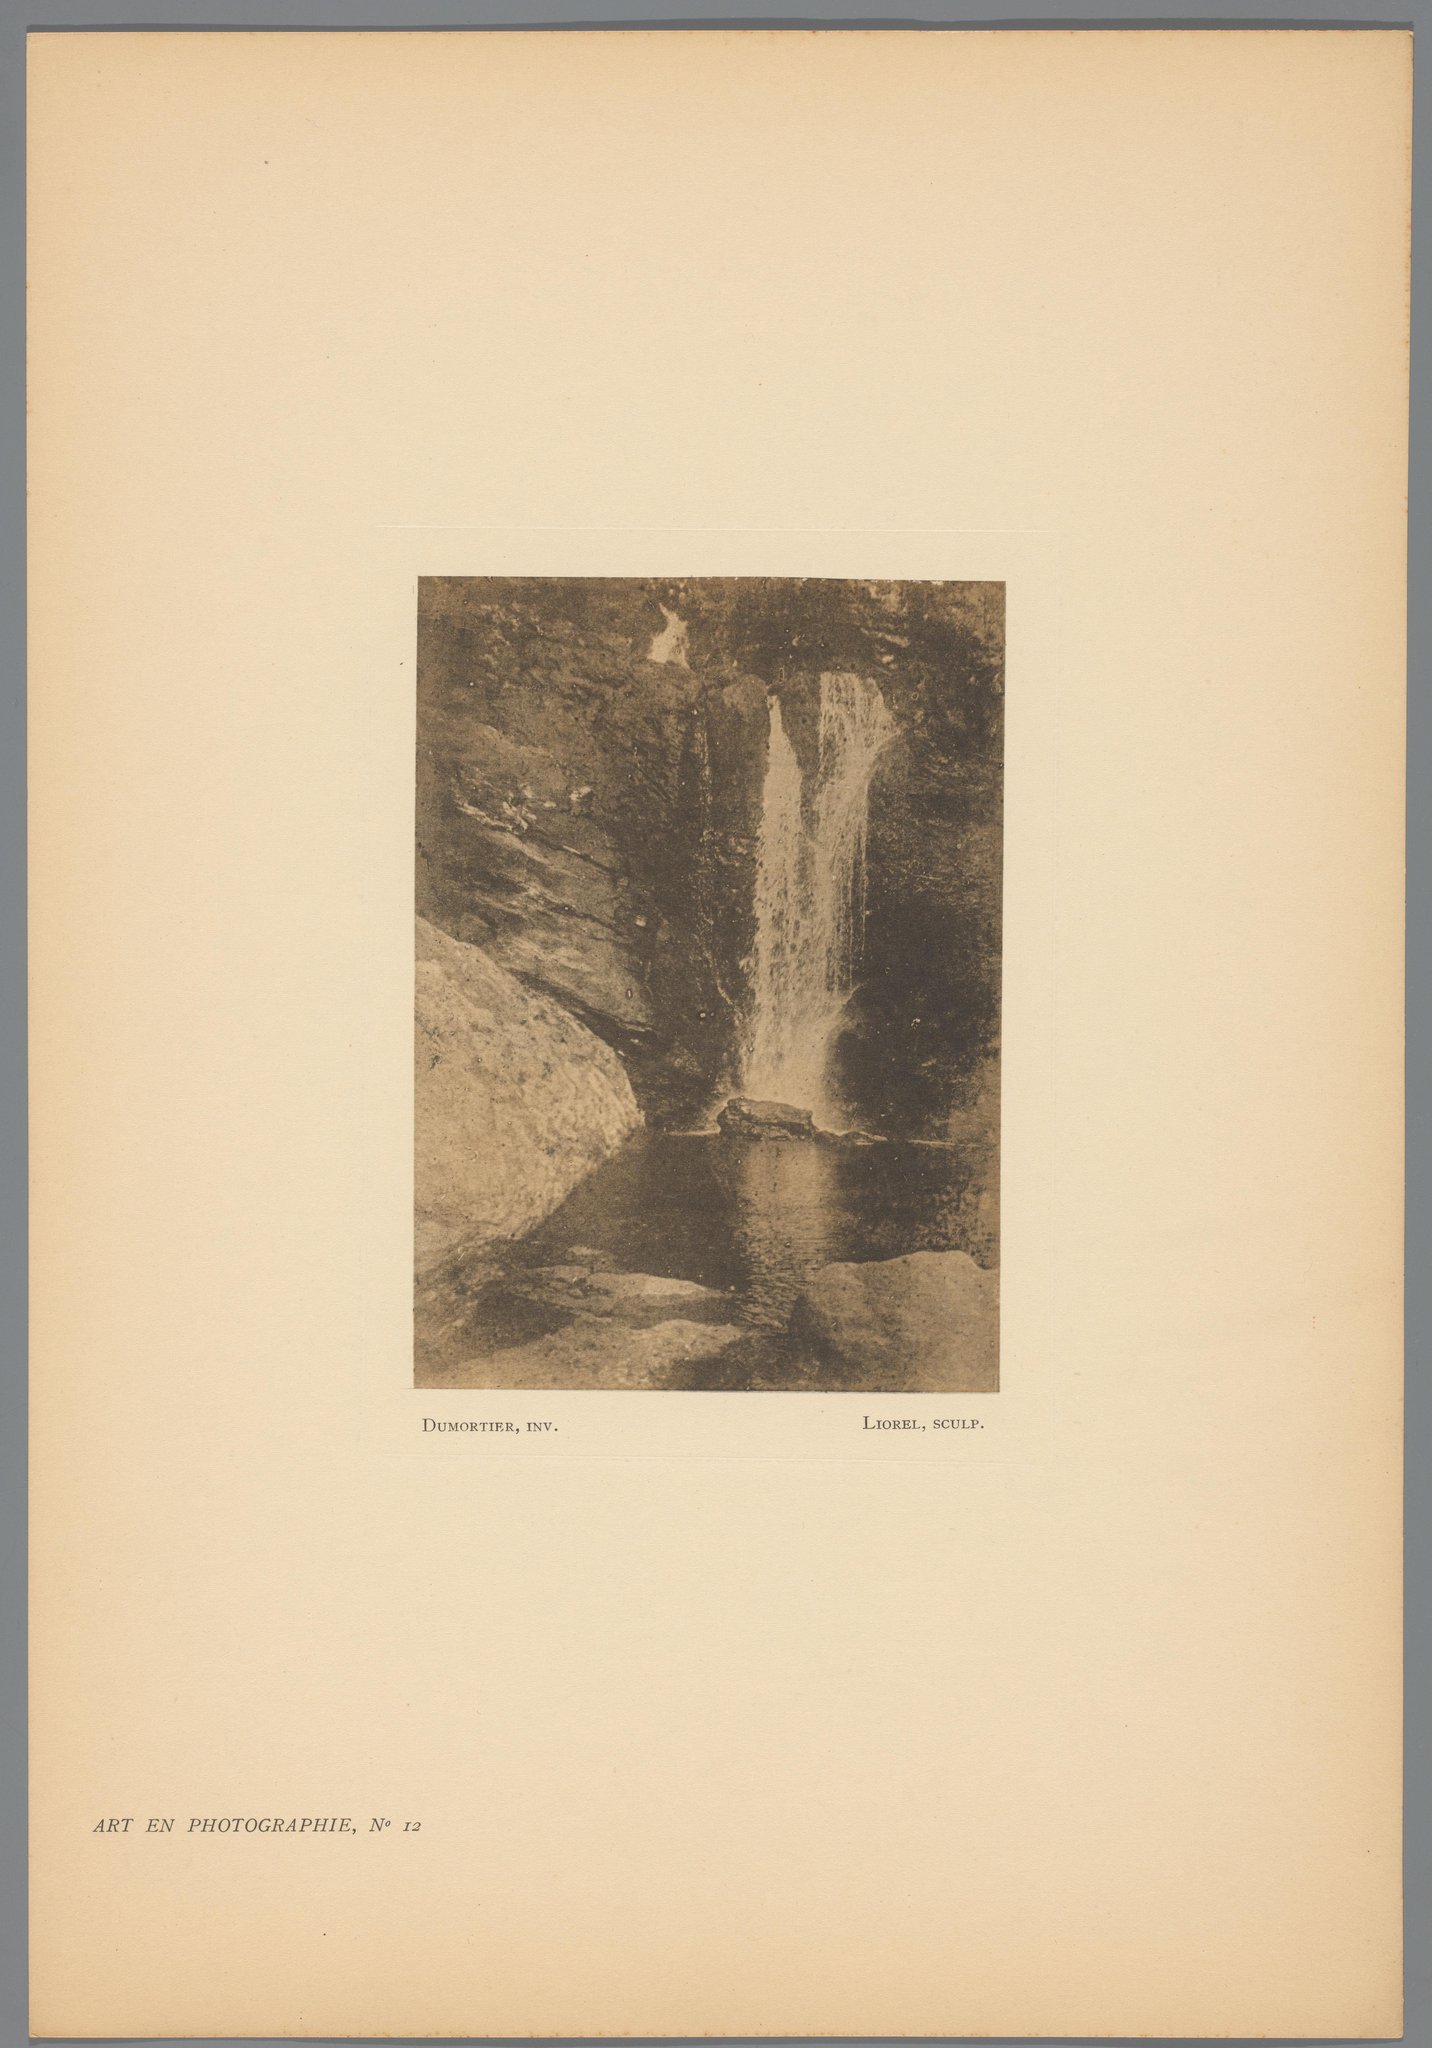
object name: photomechanical print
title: Waterval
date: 1896-1901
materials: paper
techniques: photograph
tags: waterfall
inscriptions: inscription: ‘ART EN PHOTOGRAPHIE, No 12’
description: Deze prent maakt deel uit van een omslag met 54 prenten op 52 bladen.